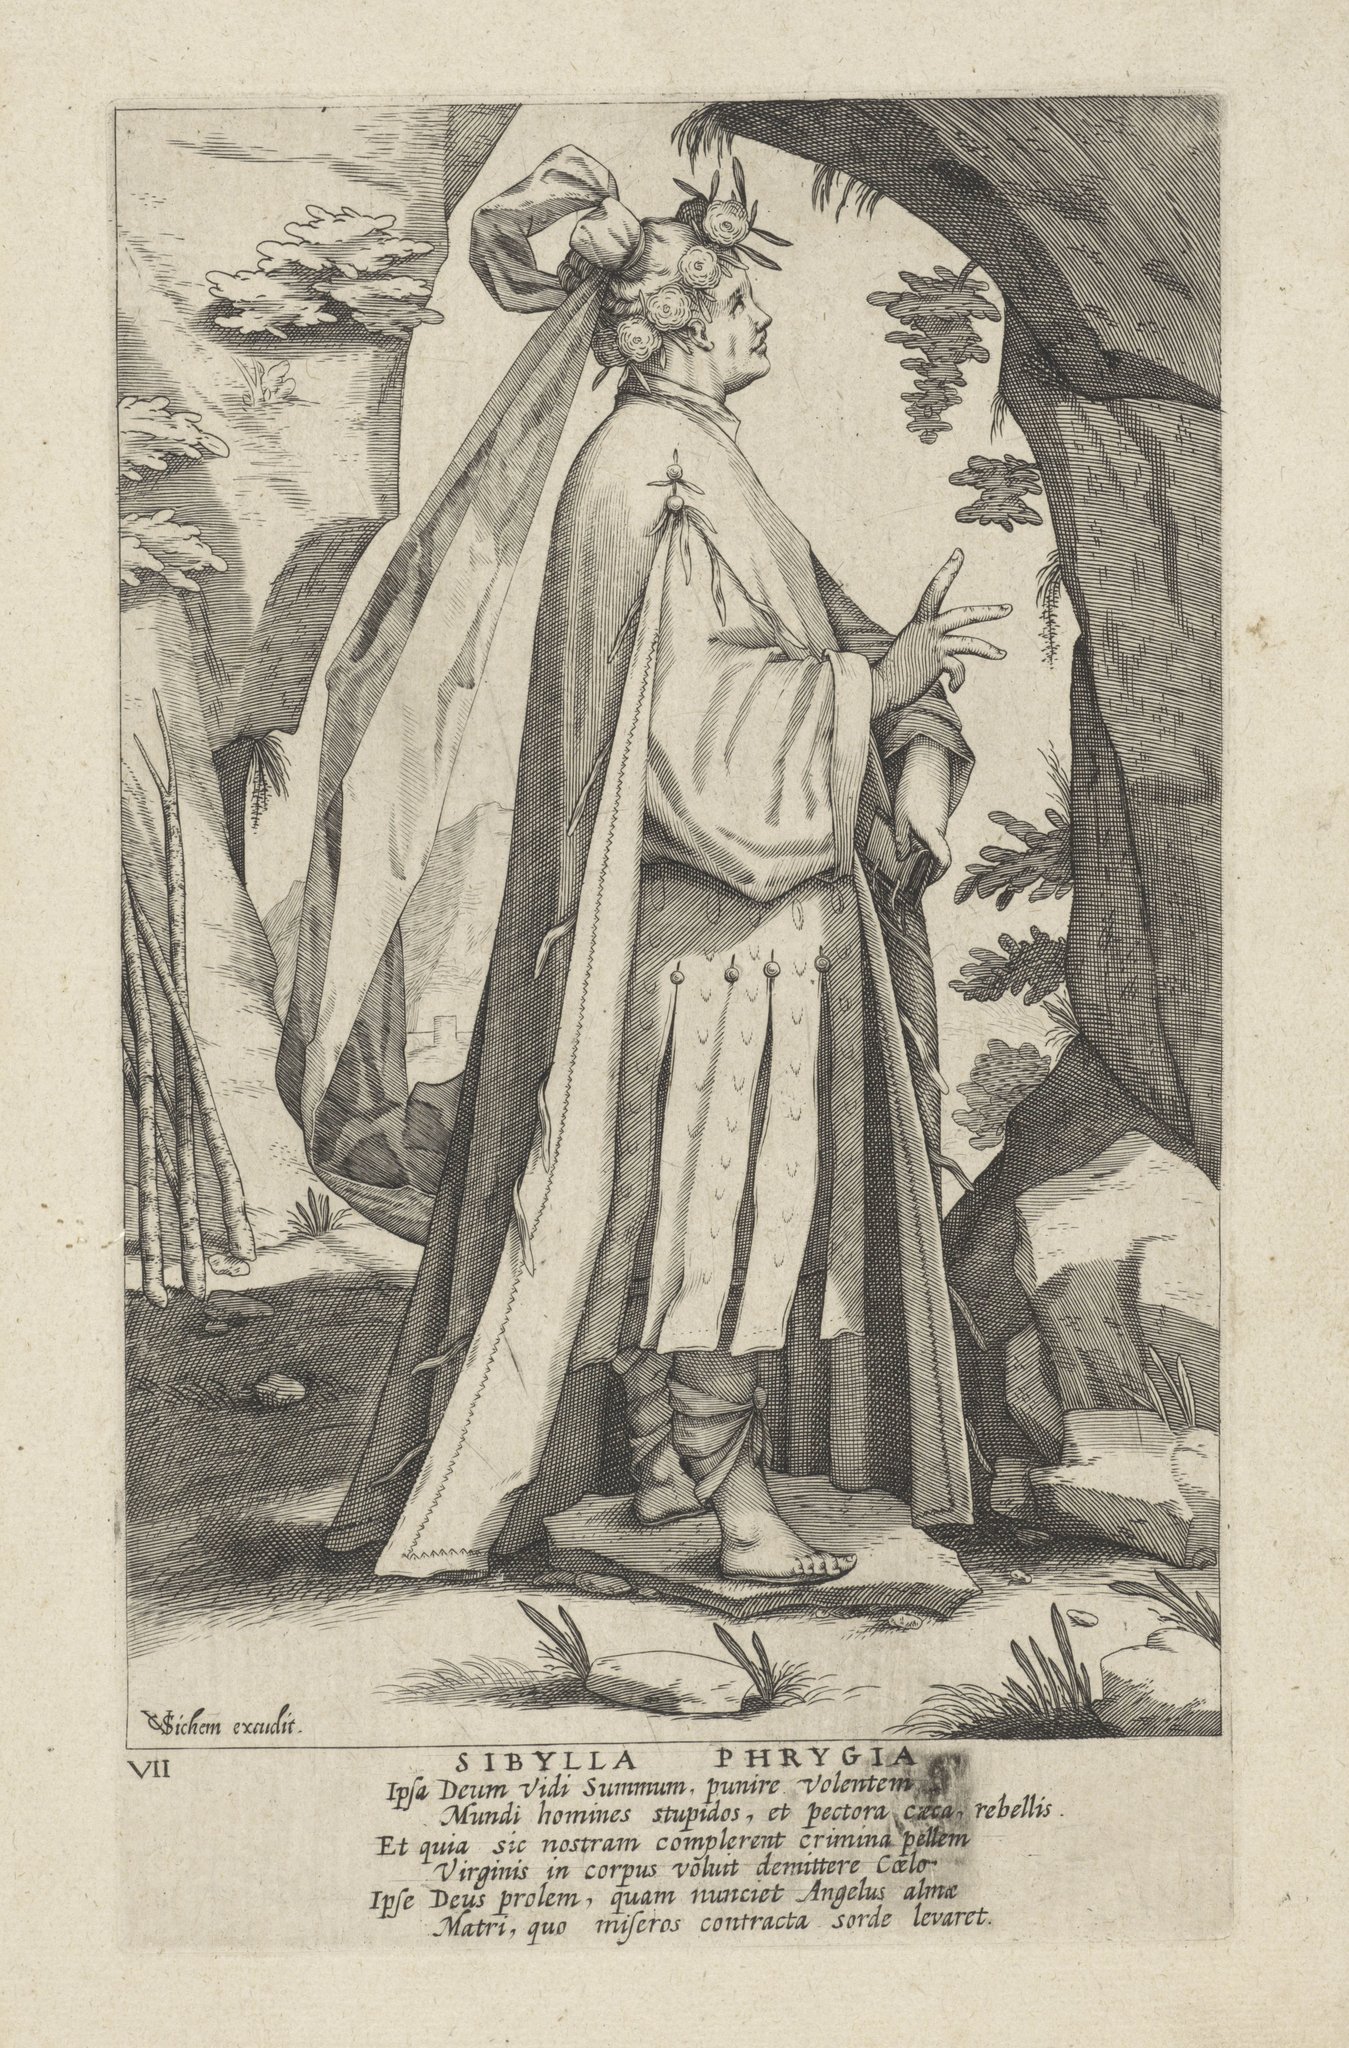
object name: print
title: Twaalf Sibillen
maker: christoffel van sichem (i)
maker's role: print maker, publisher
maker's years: 1546-1624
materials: paper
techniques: engraving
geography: amsterdam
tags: sibyls (with name)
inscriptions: collector's mark: Lugt 2228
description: Prent tevens gebruikt in: (Onuphrius Panvinius). Beschryvinghe ende heerelĳcke afbeeldinghe der twaelf Sibyllen. Vertaald uit het Latijn door R. Lubbaeus. Amsterdam: C. van Sichem, 1608.